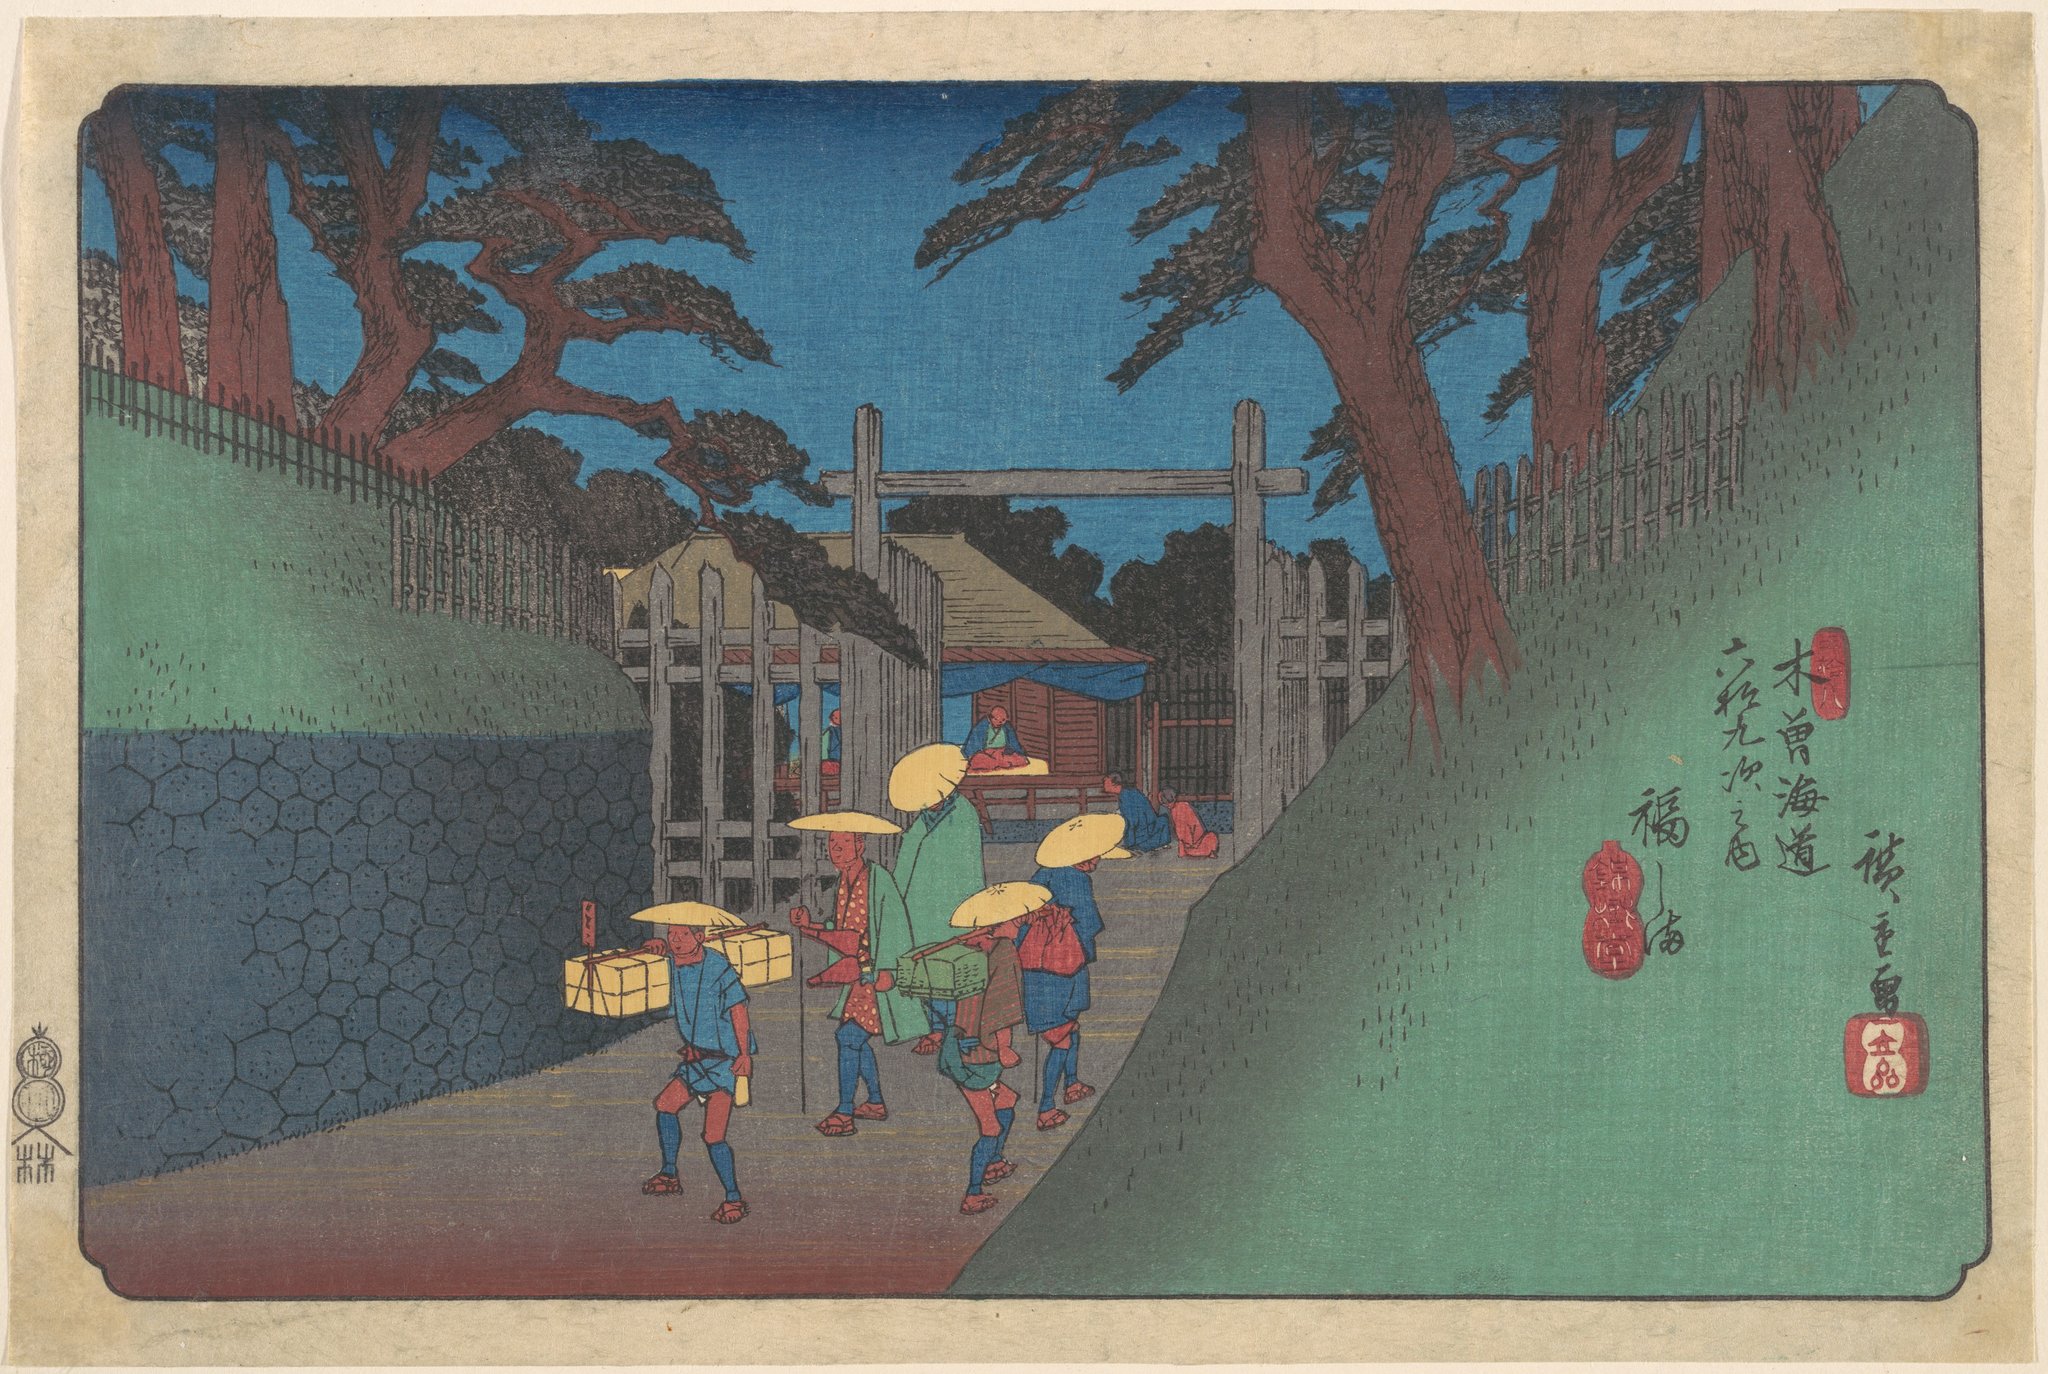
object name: print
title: Fukushima Station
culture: japanese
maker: utagawa hiroshige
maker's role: artist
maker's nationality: japanese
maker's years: 1797-1858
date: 1837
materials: ink, paper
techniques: woodblock print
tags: human figures,roads,trees,working